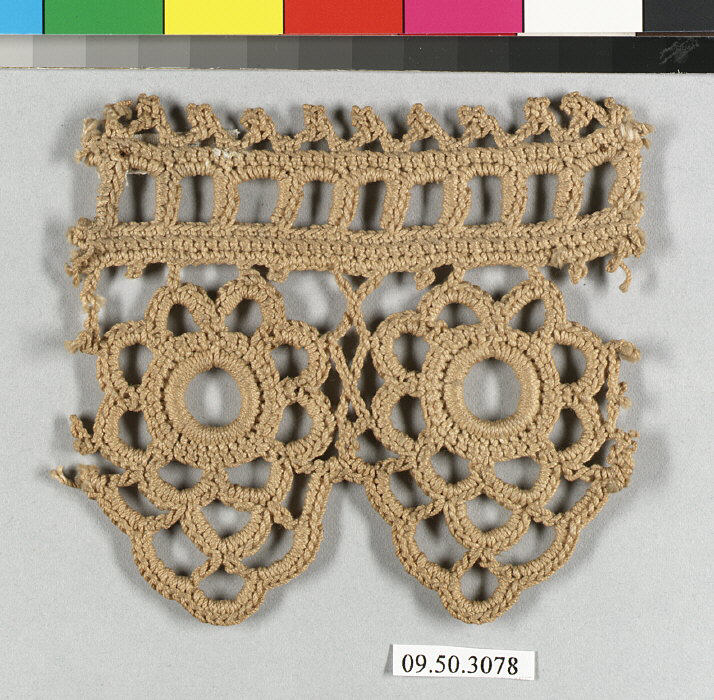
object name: piece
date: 1801-1900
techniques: crochet